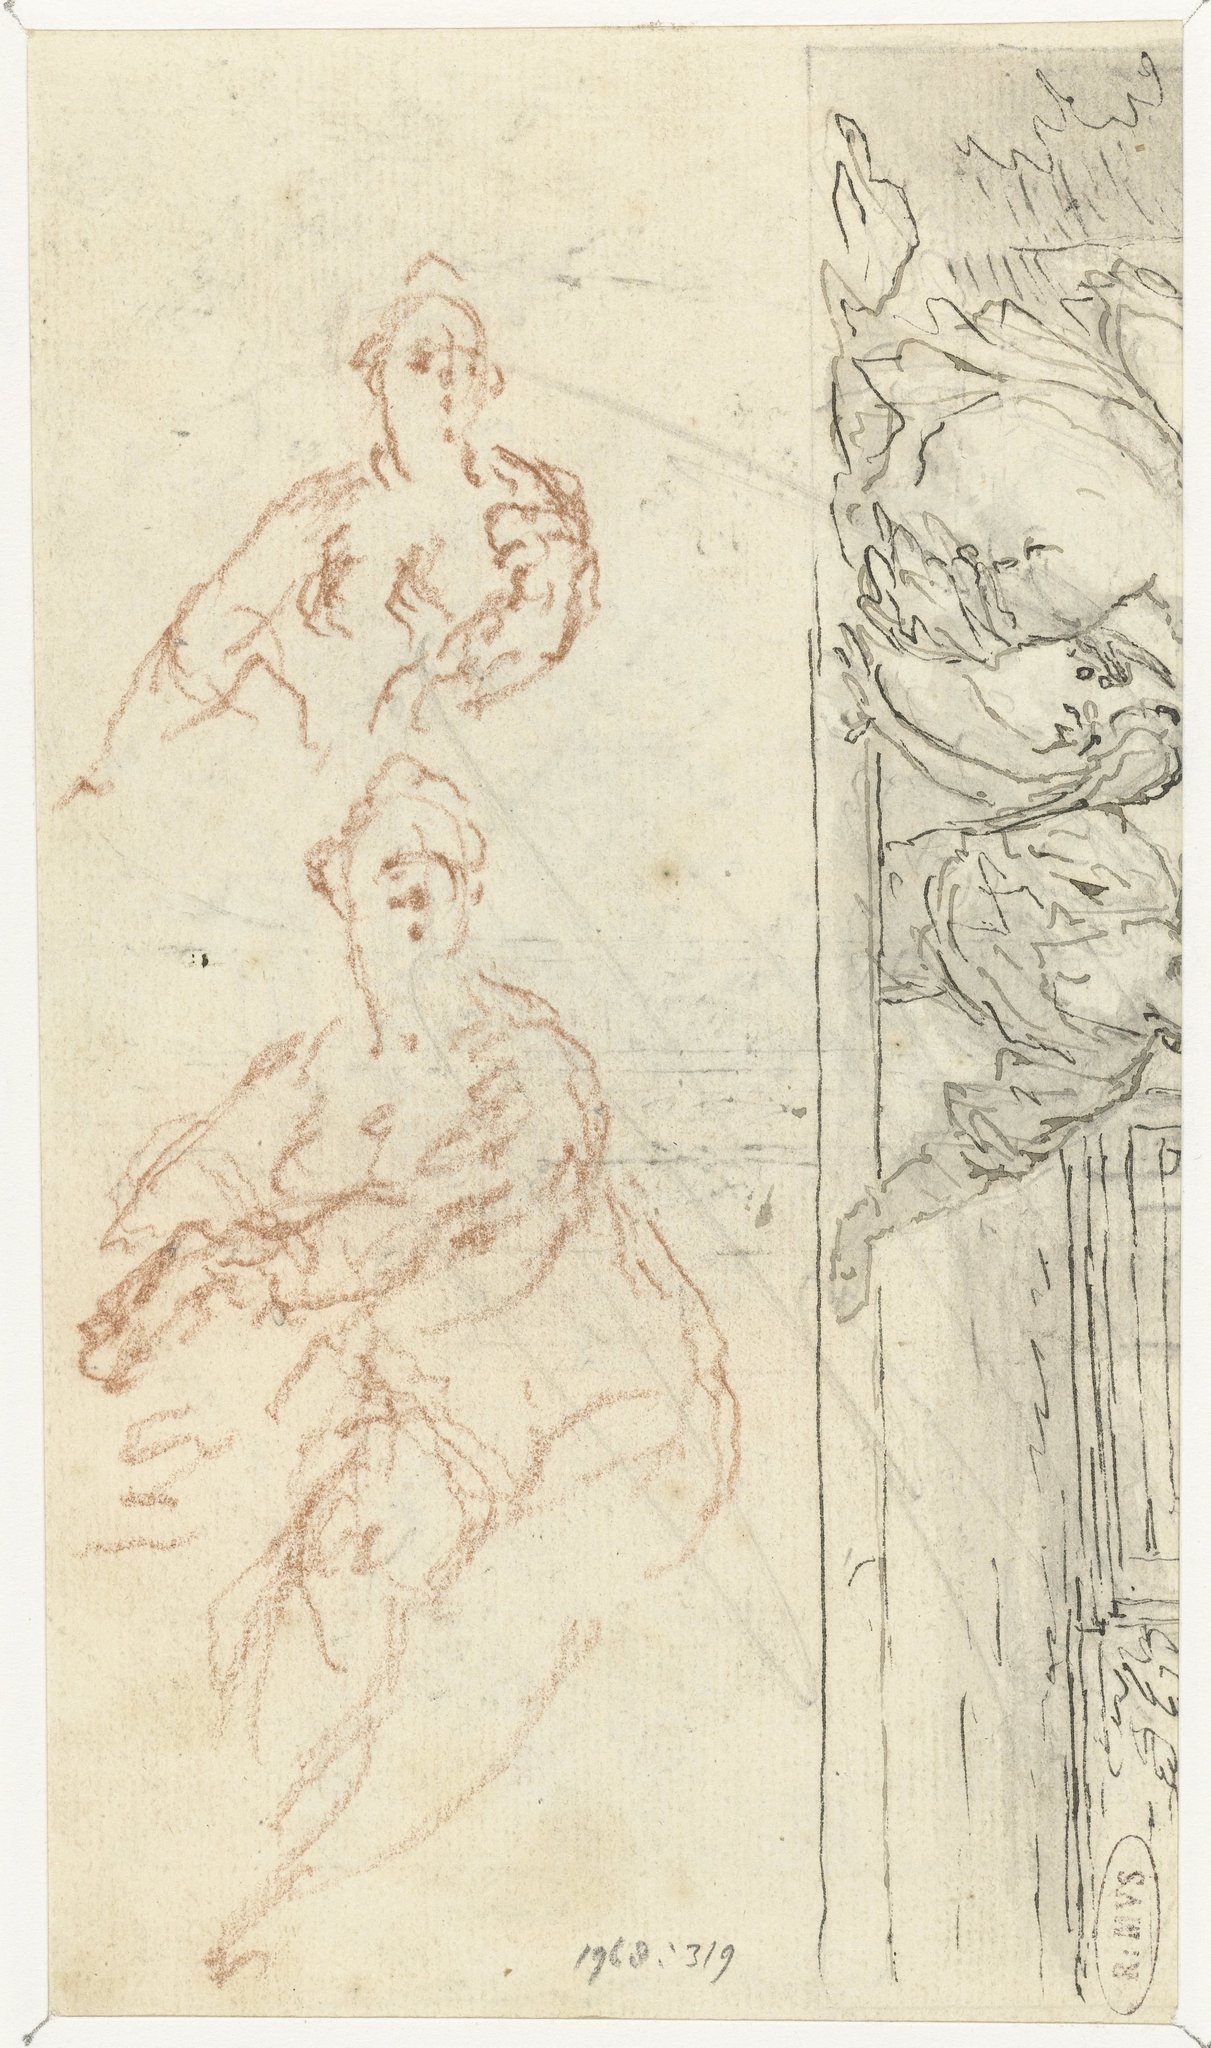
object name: design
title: Fragment van een tuinlandschap met figuren en twee studies van een vrouw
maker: dionys van nijmegen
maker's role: draughtsman, painter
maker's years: 1705-1798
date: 1715-1798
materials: chalk, ink, paper, pencil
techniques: brush, pen